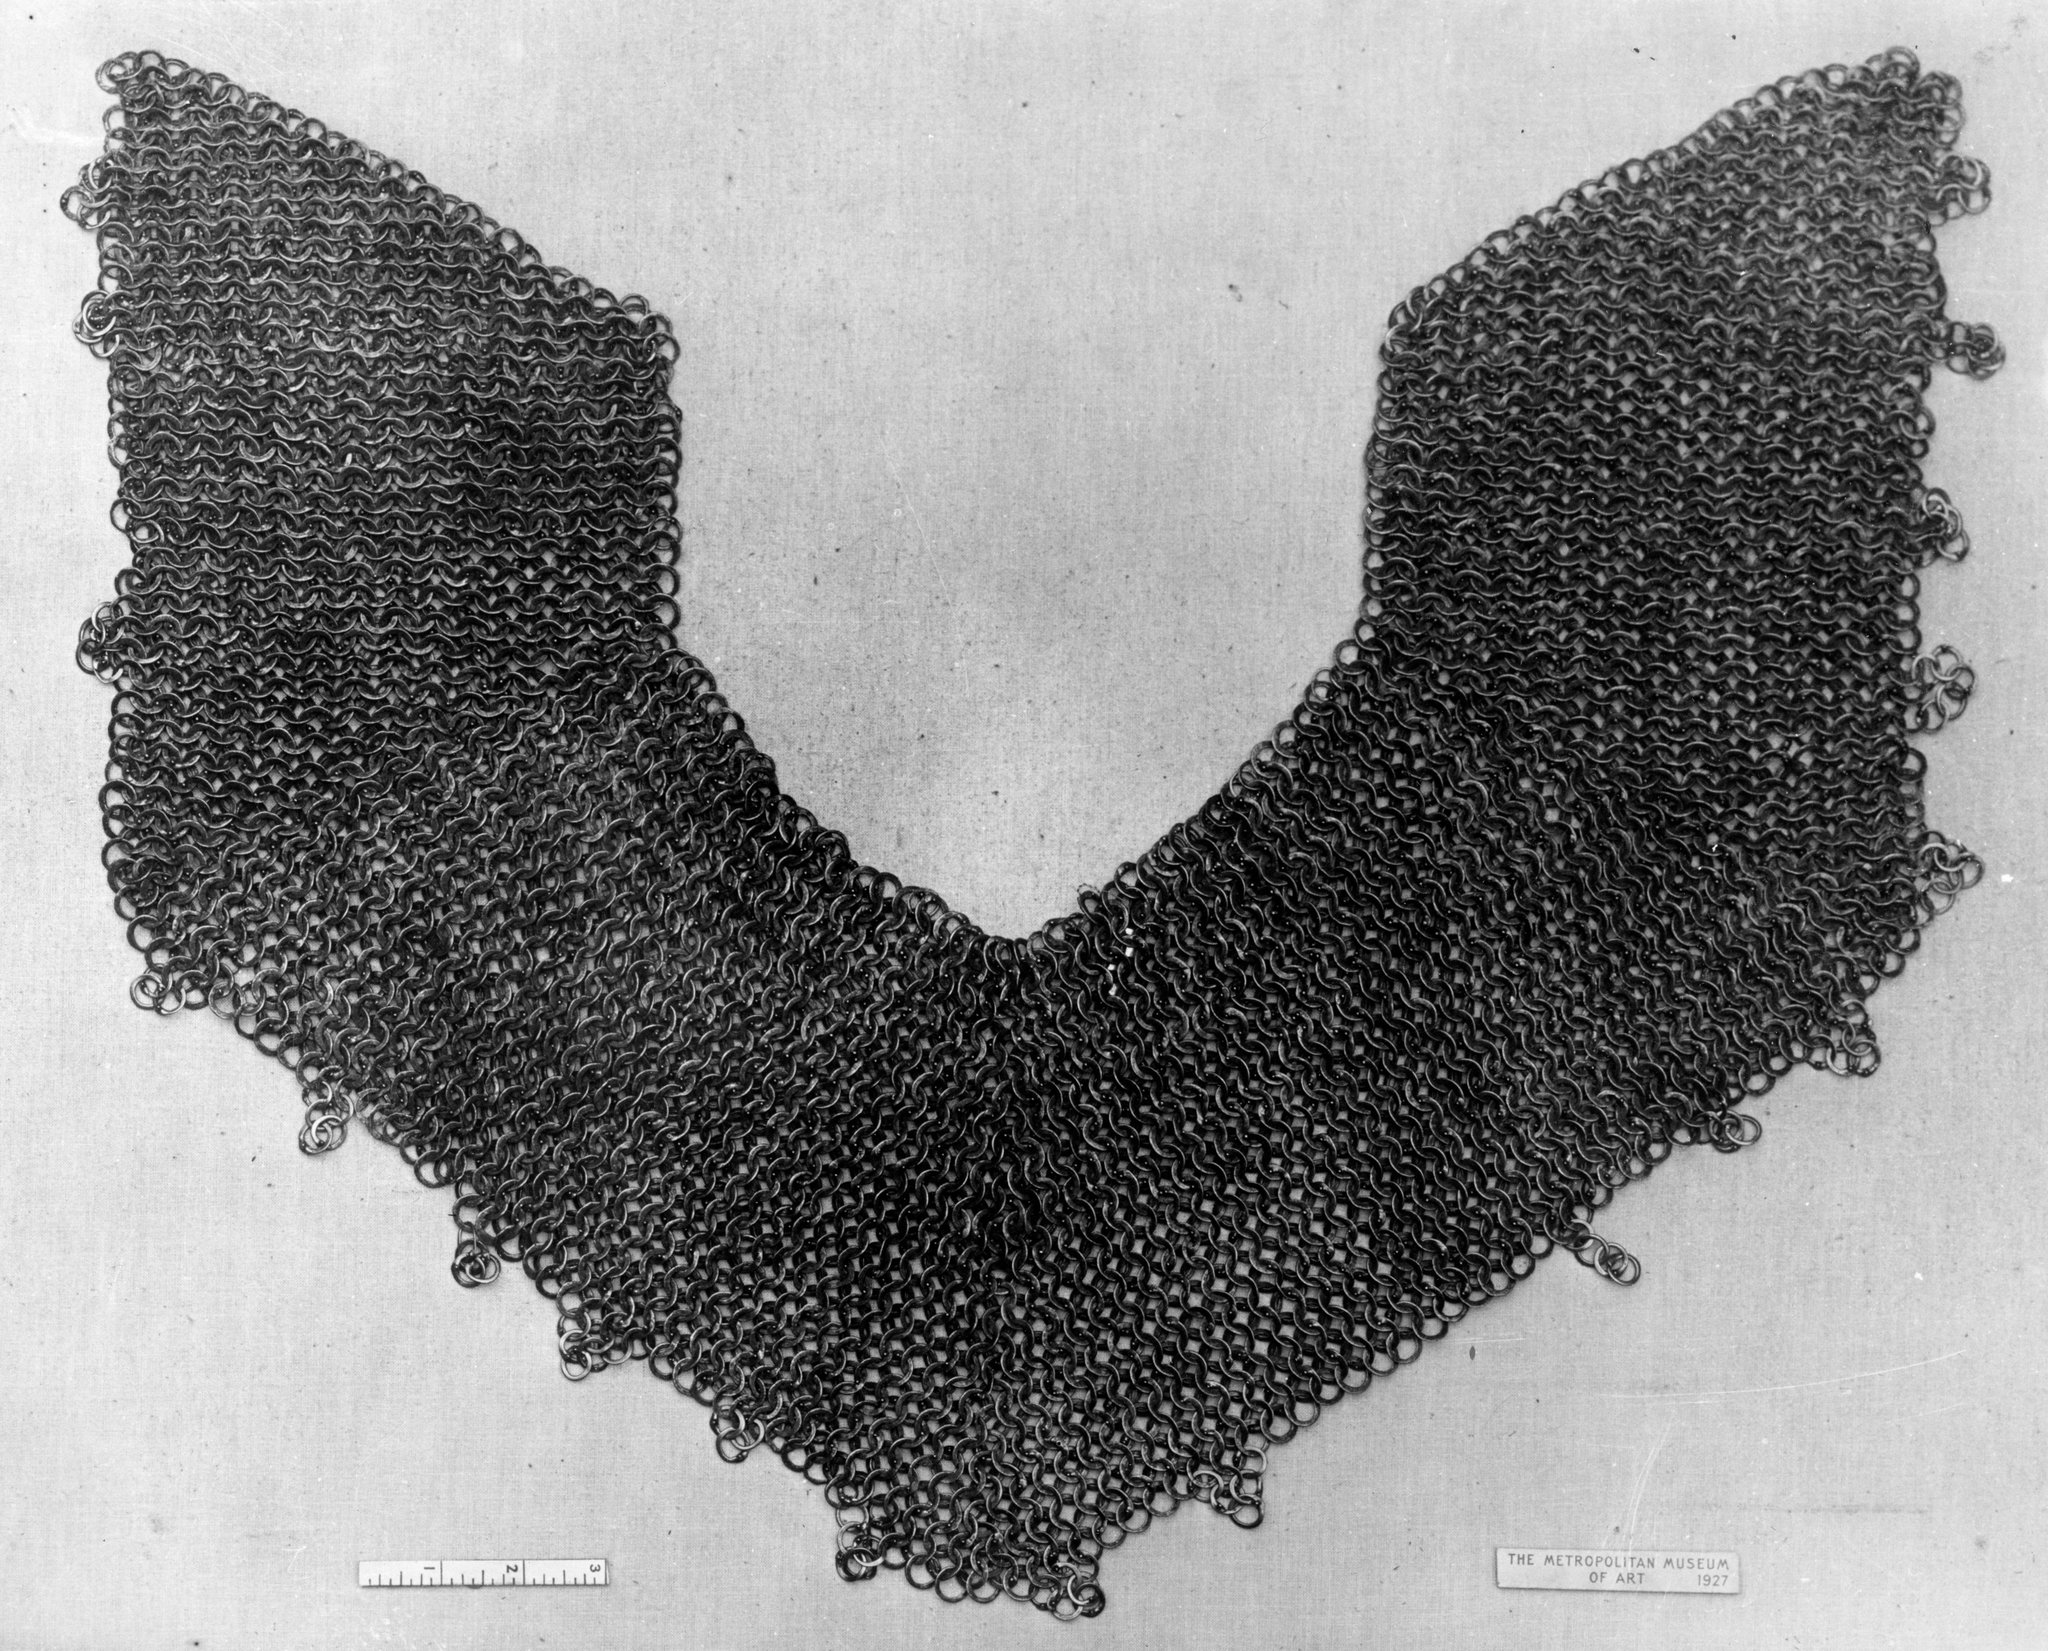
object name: collar of mail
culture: german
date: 1501-1600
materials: copper alloy, iron, steel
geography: germany